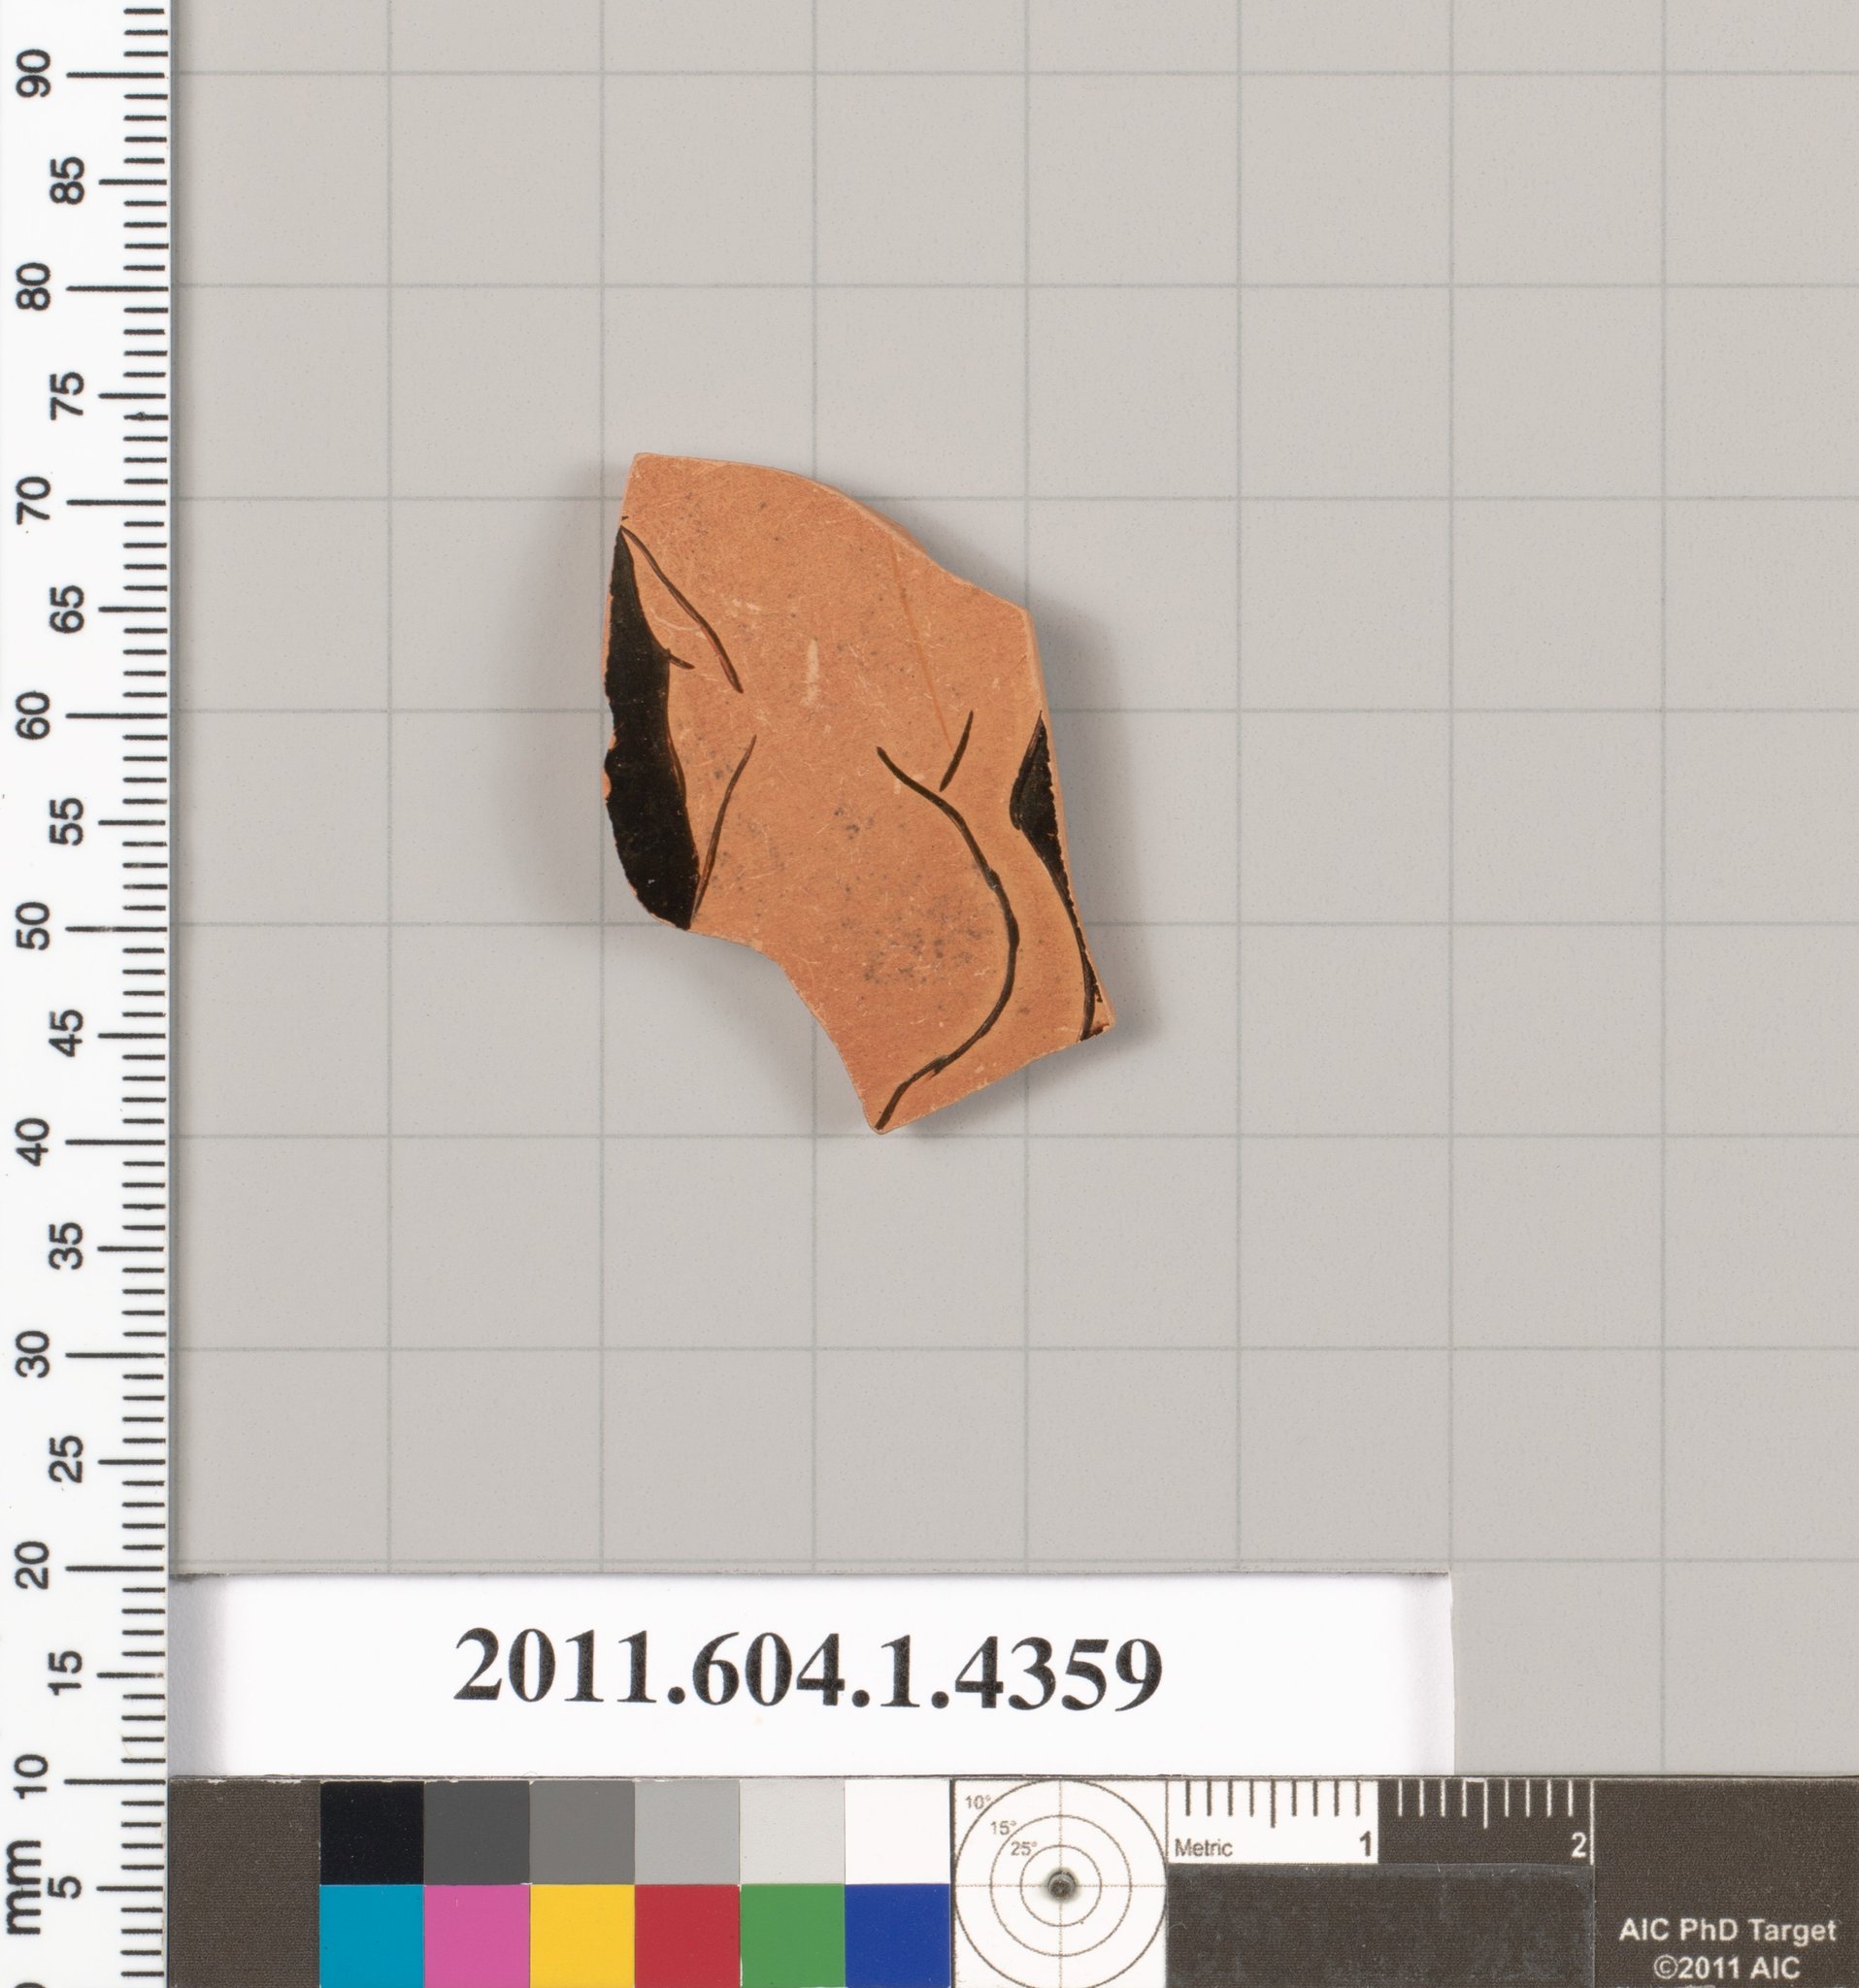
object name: kylix fragment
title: Terracotta fragment of a kylix (drinking cup)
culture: greek, attic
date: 460-450 BCE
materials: terracotta